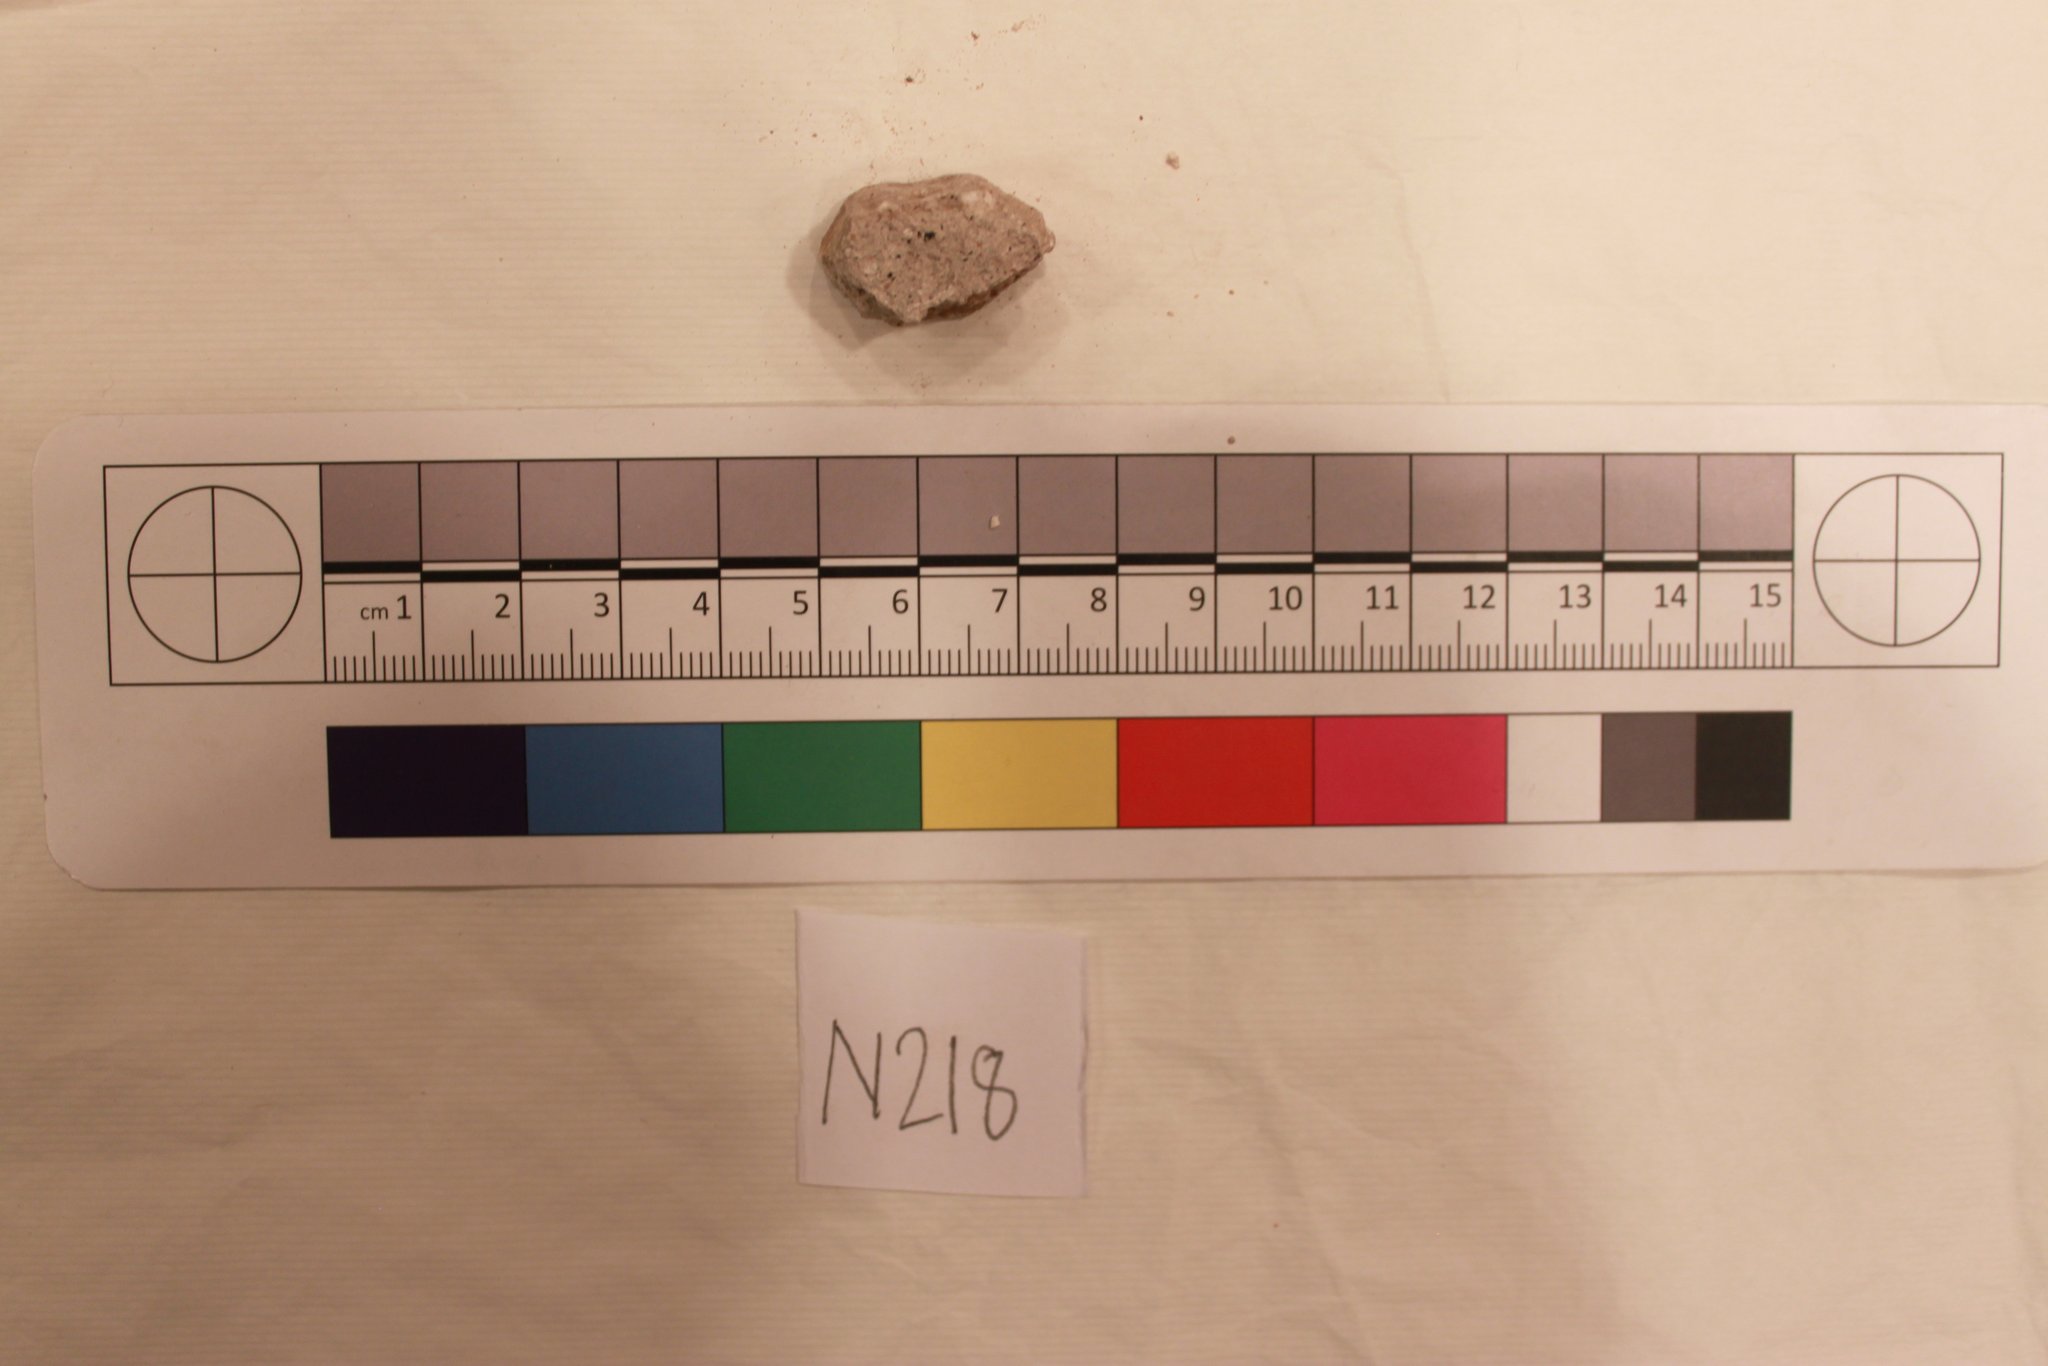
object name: fragment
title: Stucco Fragment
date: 701-1200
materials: plaster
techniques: carving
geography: iran